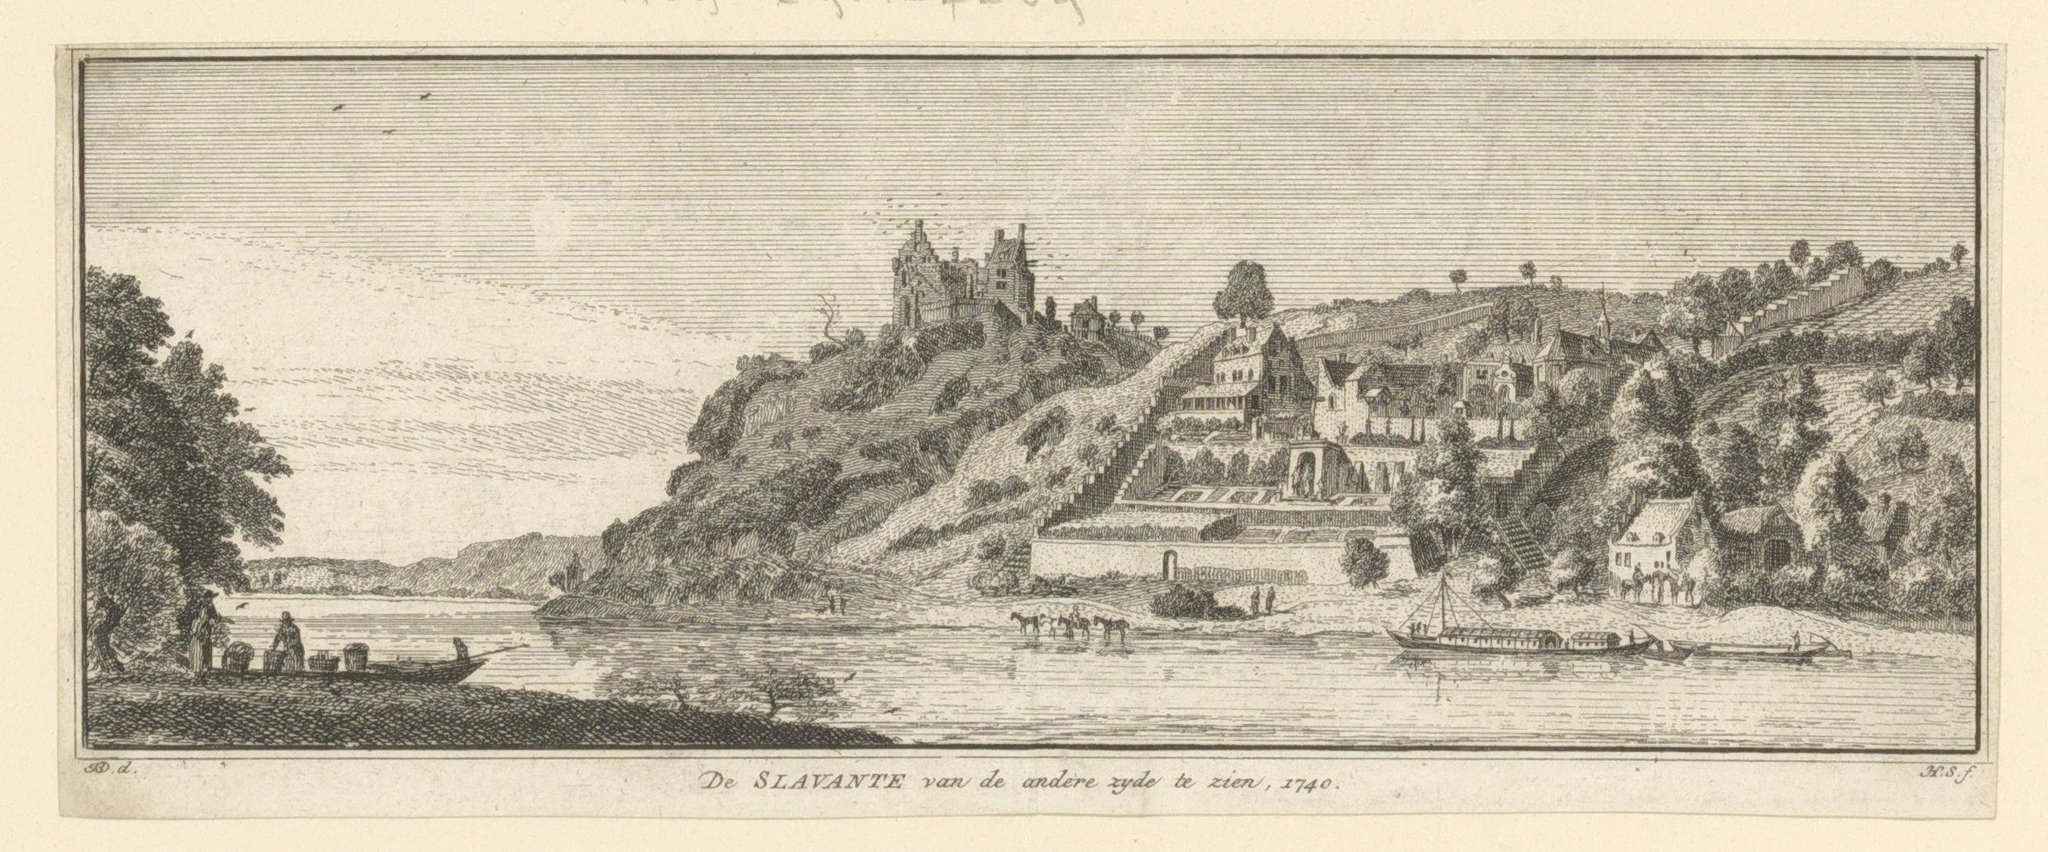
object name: print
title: Gezicht op het klooster Slavante bij Maastricht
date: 1744-1792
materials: paper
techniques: engraving, etching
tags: cloisters ~ monastery, prospect of city, town panorama, silhouette of city, maastricht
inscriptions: stamp, stamp, collector's mark: Lugt 1641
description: Prent waarschijnlijk uit: Het verheerlykt Nederland of kabinet van hedendaagsche gezigten van steden, dorpen (…). 9 dln. Amsterdam: Isaak Tirion en weduwe Isaak Tirion, 1745-1774, dl. 2 (1746). Of uit: Nederlandsche tafereelen; of eene keurige verzameling van negen honderd fraaije gezigten van steden, dorpen, sloten, oudheden (….). 9 dln. Amsterdam: Jan de Groot, 1792, dl. 2.